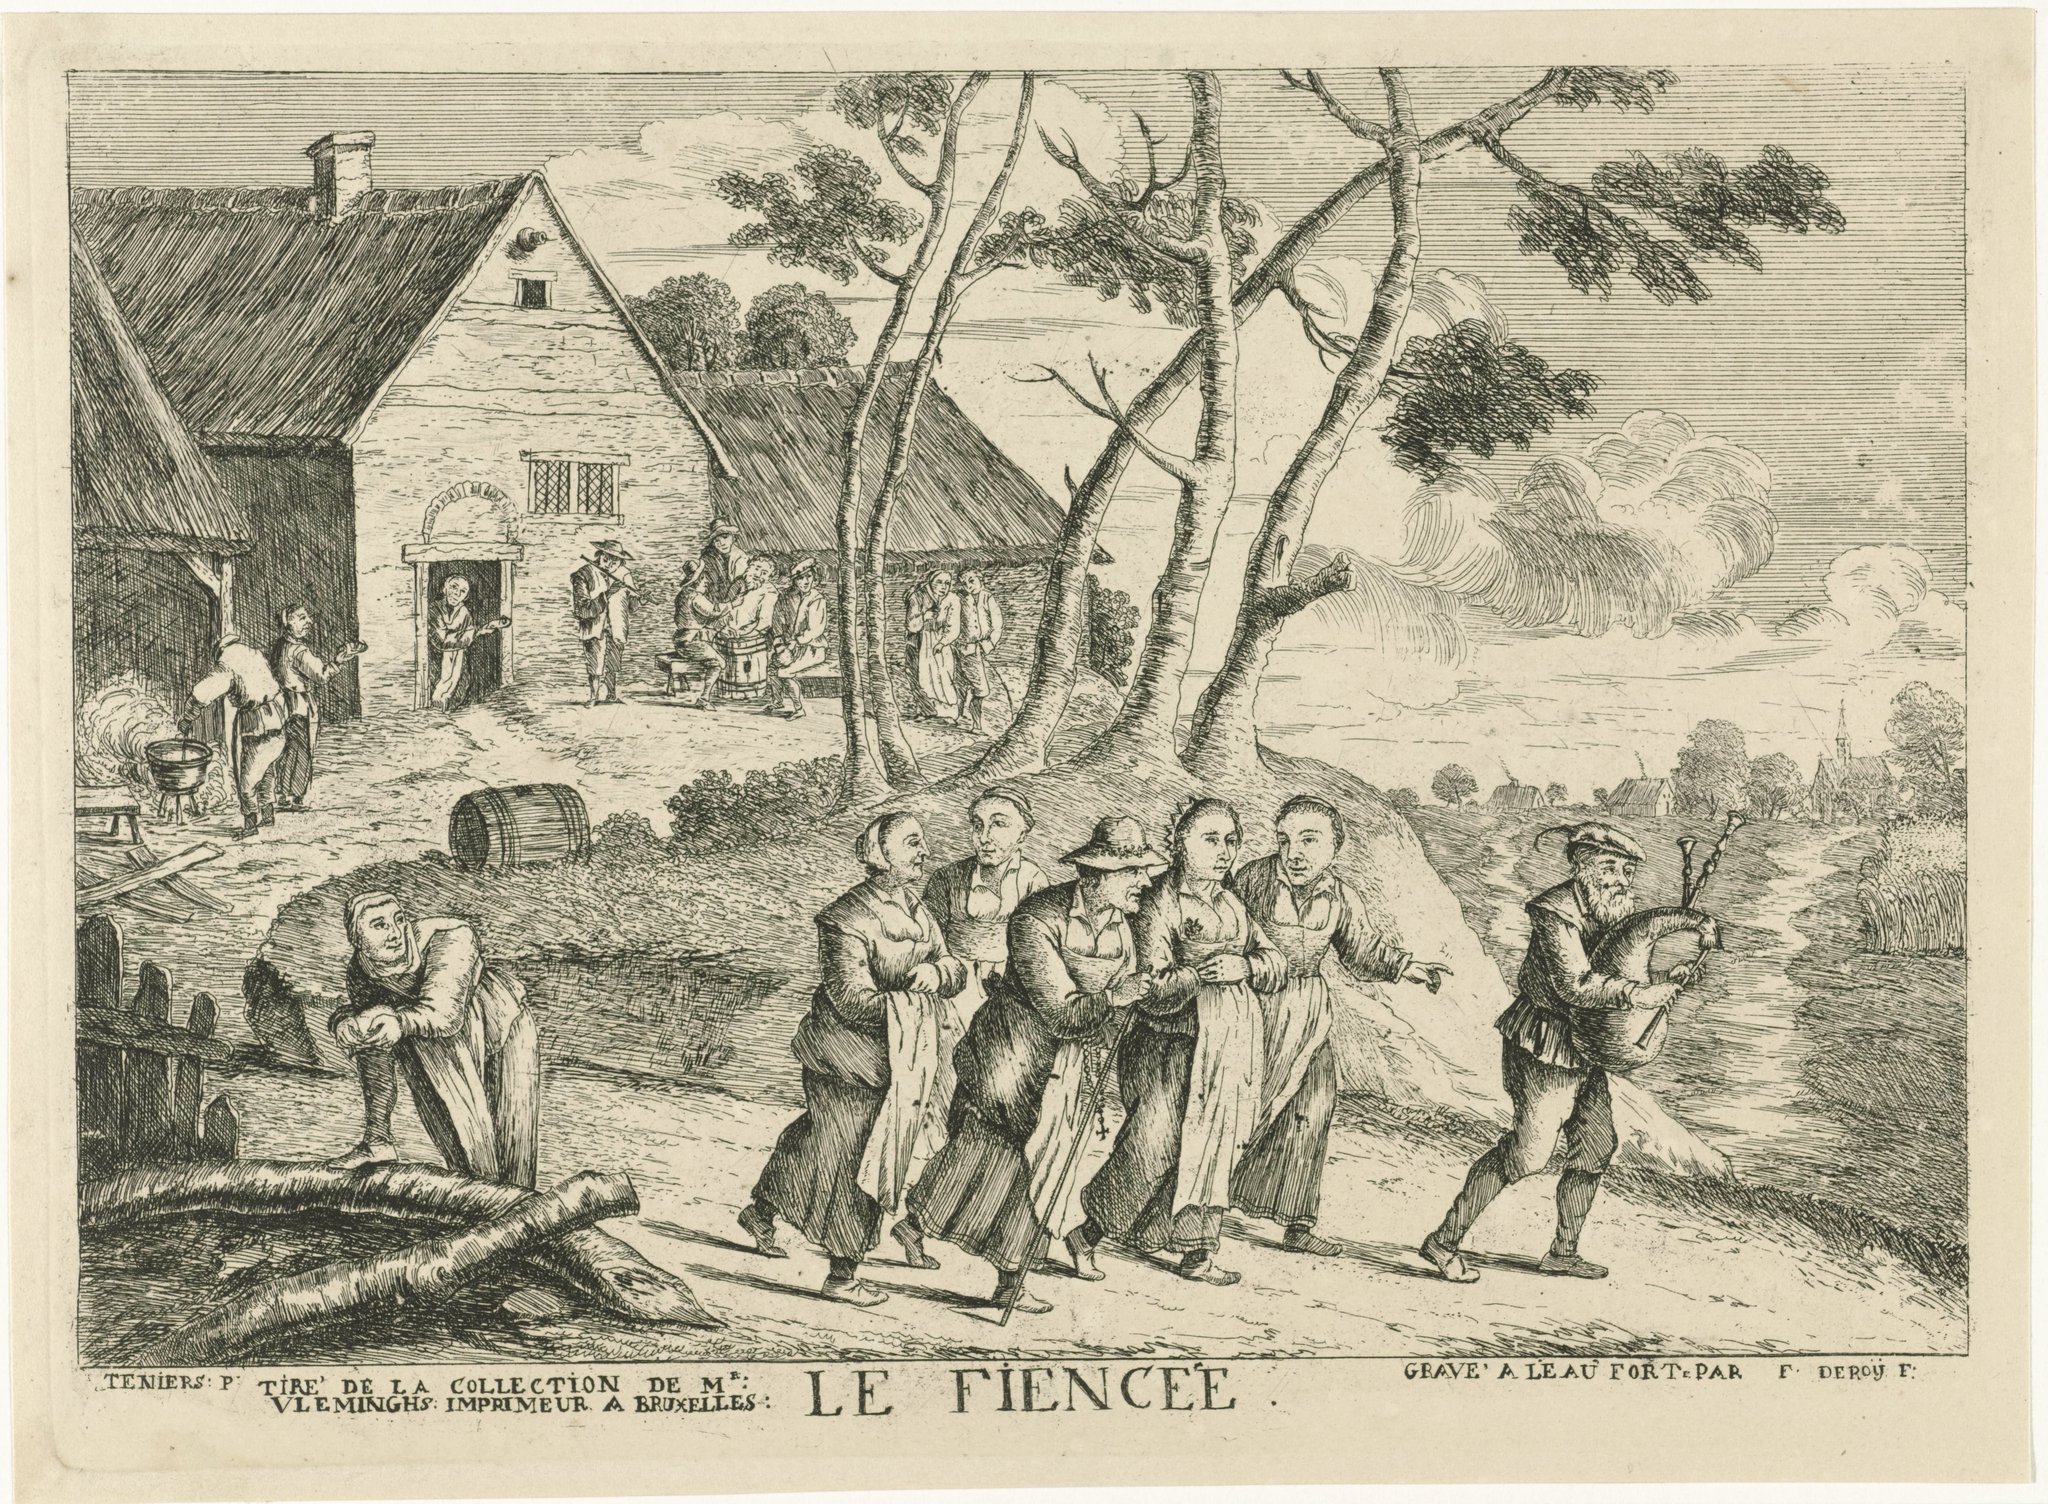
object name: print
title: Bruid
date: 1758-1762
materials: paper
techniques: etching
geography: southern netherlands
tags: church (exterior), bagpipe, musette - cc - out of doors, bride (in wedding-dress)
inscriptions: collector's mark: Lugt 2228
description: Een bruid (de vrouw met de kroon) loopt, vergezeld door vier personen, achter een doedelzakspeler aan. Links een huis waarvoor verschillende figuren staan.